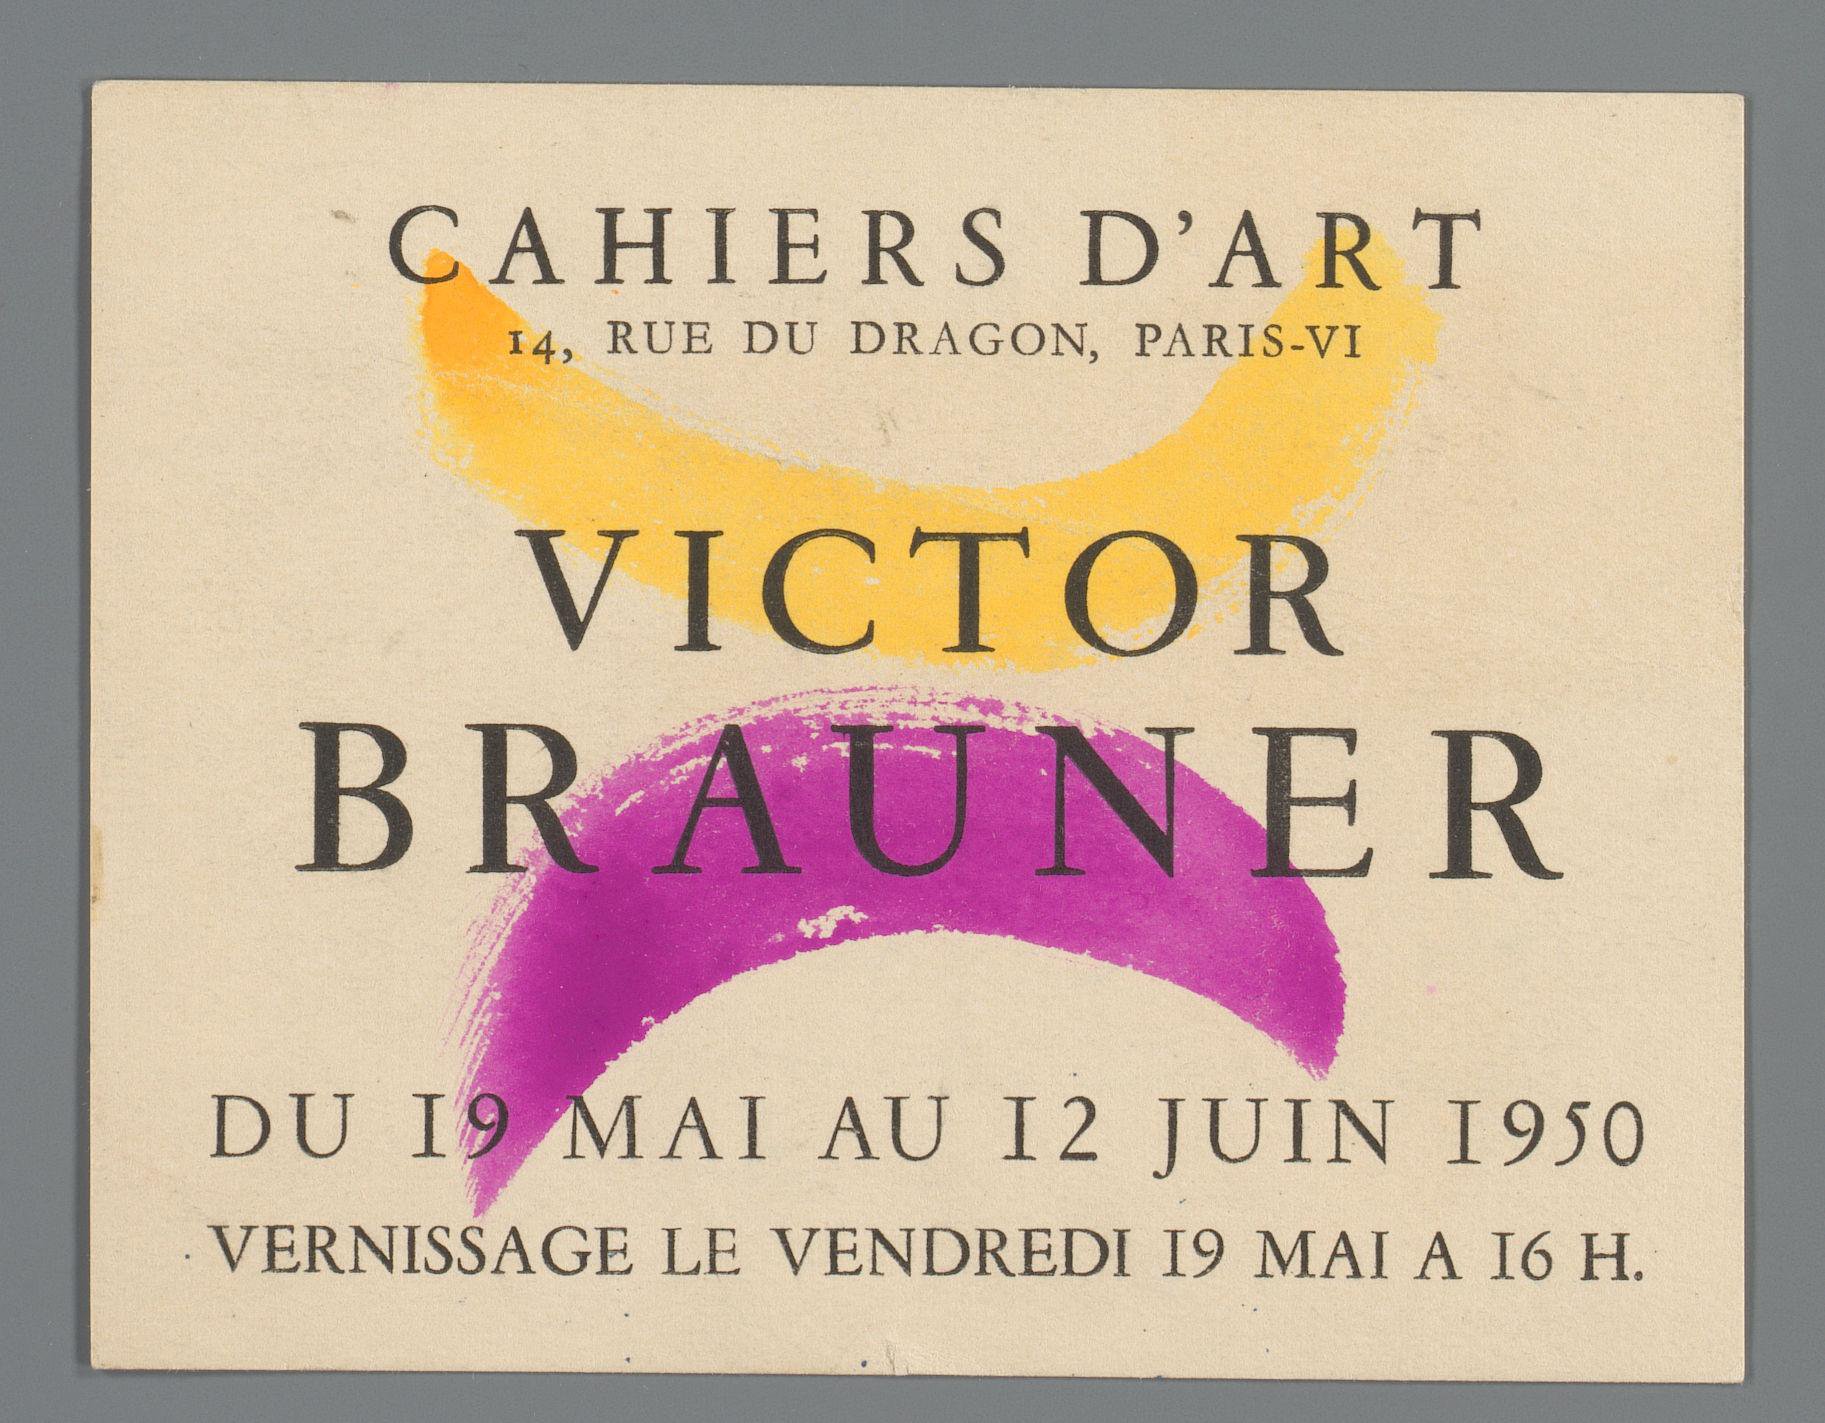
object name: photomechanical print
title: Uitnodiging voor de opening van de tentoonstelling 'Victor Brauner'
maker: Anonymous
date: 1950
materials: paper, watercolor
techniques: brush, printing block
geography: paris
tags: paris, painter, victor brauner, portrait, self-portrait of artist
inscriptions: address: ‘Mr. D.C. Roell Conservateur en chef des Muséen de l'Etat Amsterdam Hollande’, postage stamp: ‘R[epublic] F[rançaise] 5F’, : ‘Paris 72. 16 V 50 10.45 R. de l'Ouest’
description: Typografische kaart met twee gekleurde penseelstreken. Met de tekst: 'Cahiers d'Art 14, Rue du Dragon, Paris-VI. Victor Brauner du 19 mai au 12 juin 1950. Vernissage le vendredi 19 mai a 16 h.'. Op de achterzijde geadresseerd.